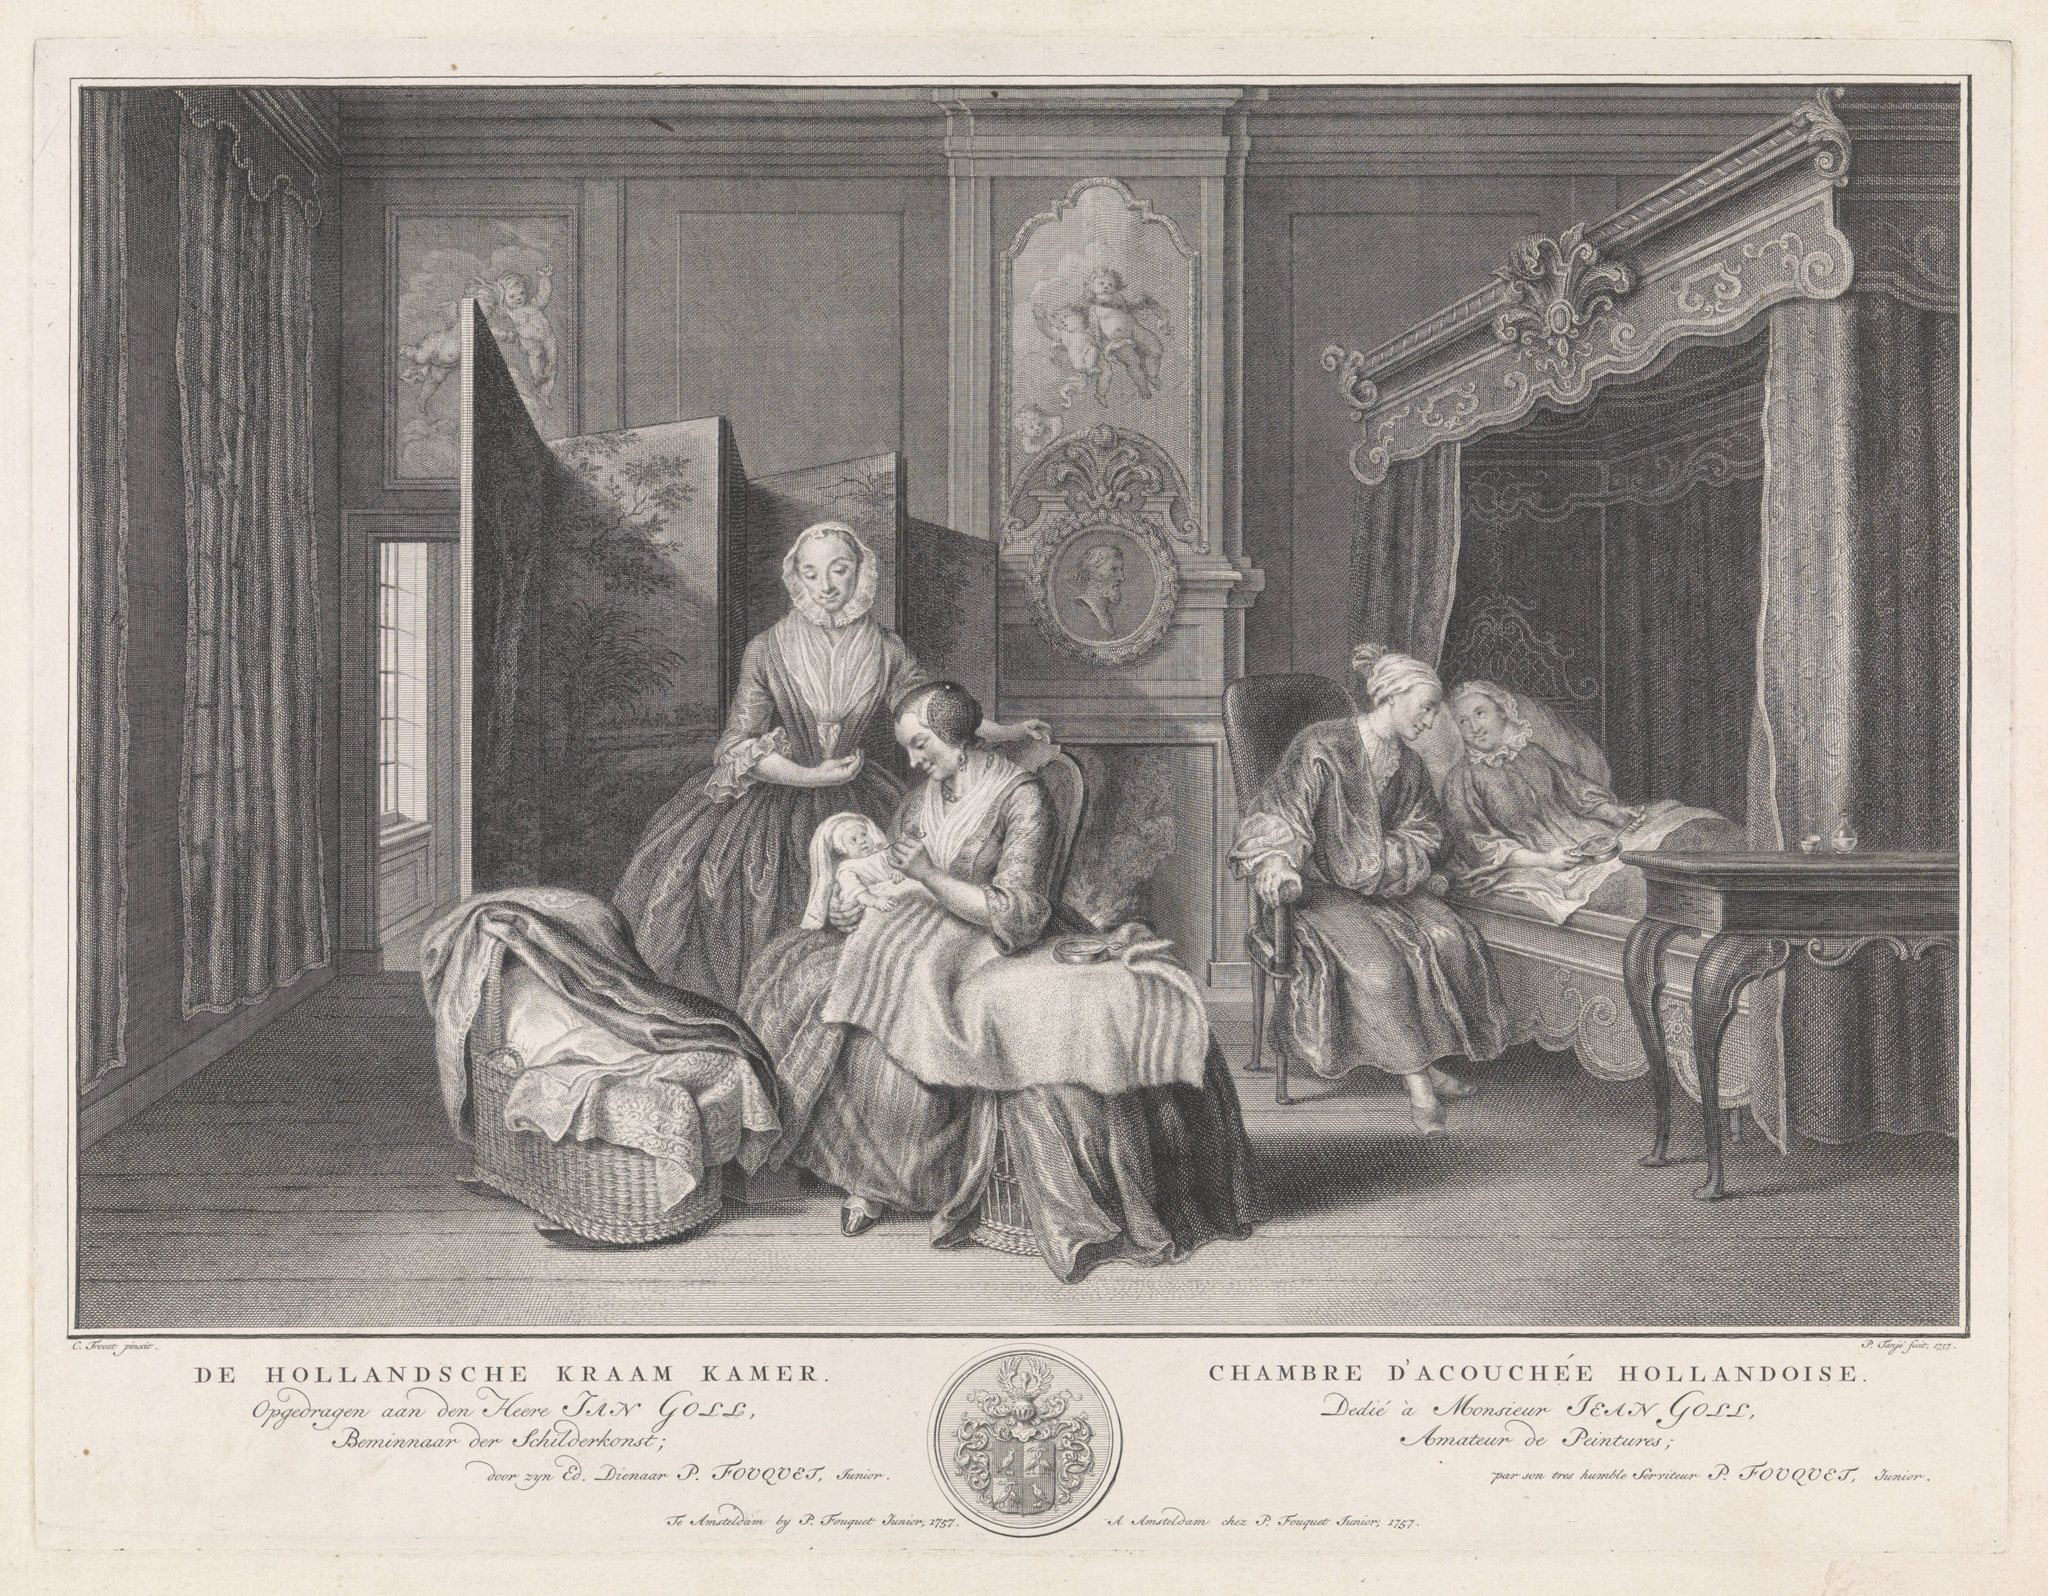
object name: print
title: Hollandse kraamkamer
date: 1757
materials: paper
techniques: engraving, etching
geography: amsterdam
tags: bed with tester, cradle, crib, lying-in room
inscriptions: collector's mark: Lugt 2228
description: In de kraamkamer geeft een min de baby te eten, terwijl een andere vrouw toekijkt. Rechts ligt de moeder in een hemelbed. Naast haar zit haar man. Onderaan in de marge het wapenschild van Johann Goll van Frankenstein, die het originele schilderij in bezit had en aan wie de prent is opgedragen.